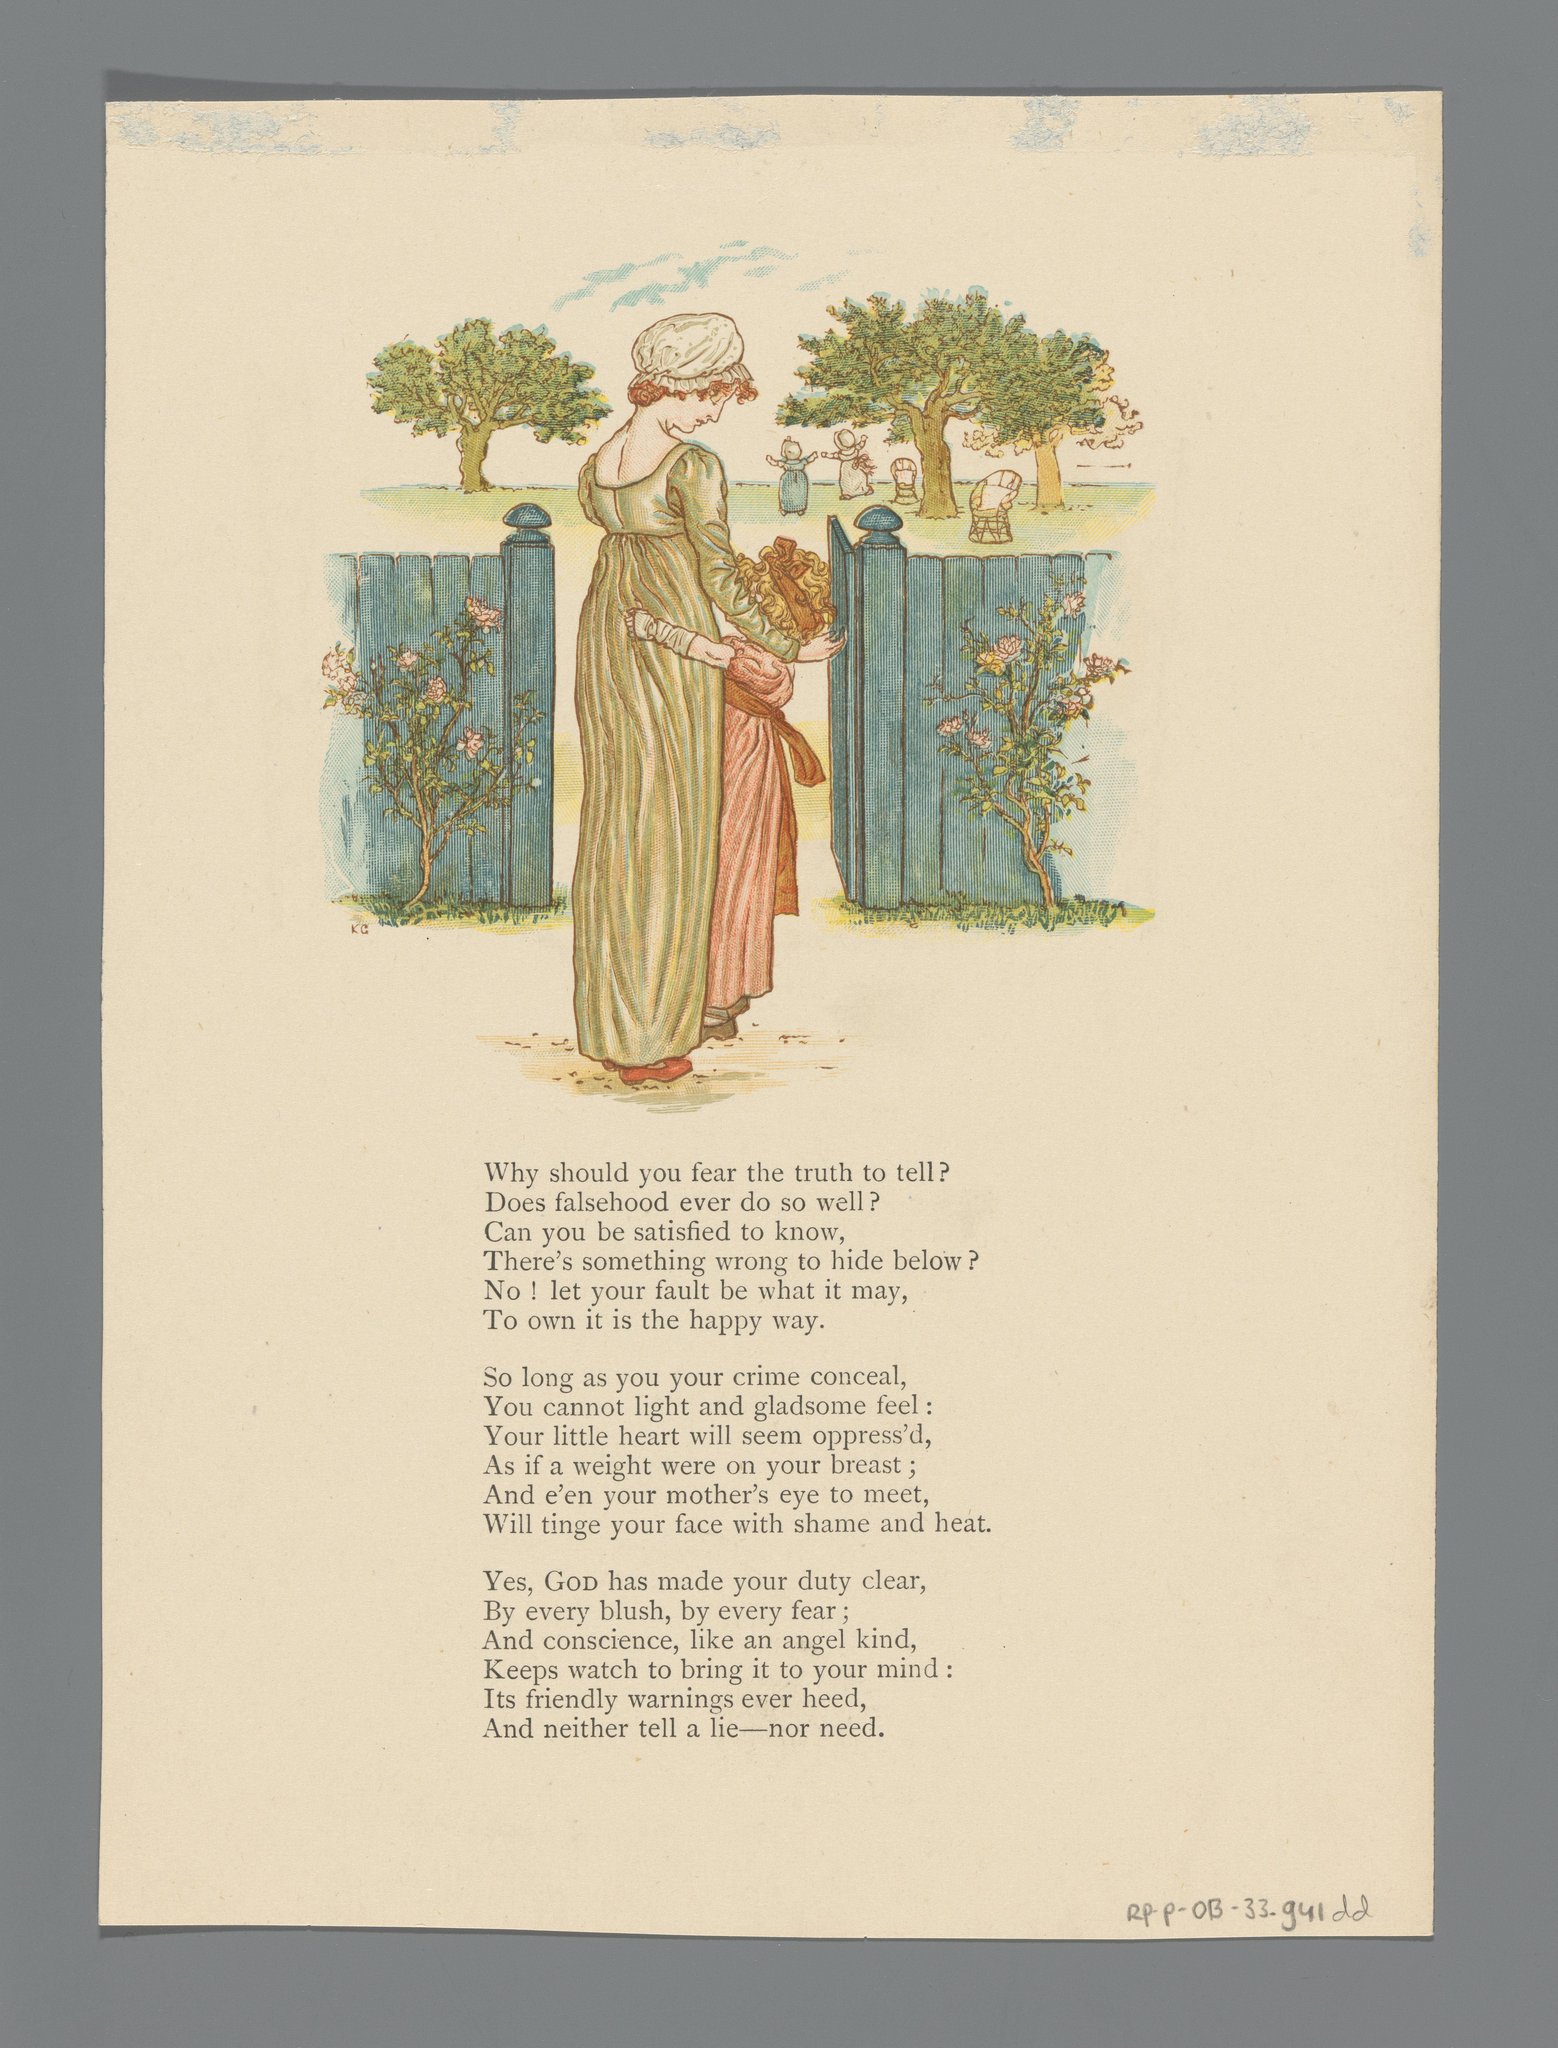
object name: book illustration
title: Moeder en dochter bij een tuinhek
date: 1883-1927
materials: paper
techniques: wood engraving, letterpress printing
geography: london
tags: garden, gate, entrance, mother and daughter(s) (family group)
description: Prent uit: Jane en Ann Taylor. Little Ann and other poems. Londen: George Routledge & Sons, [1883], p. 23. Of een latere uitgave.